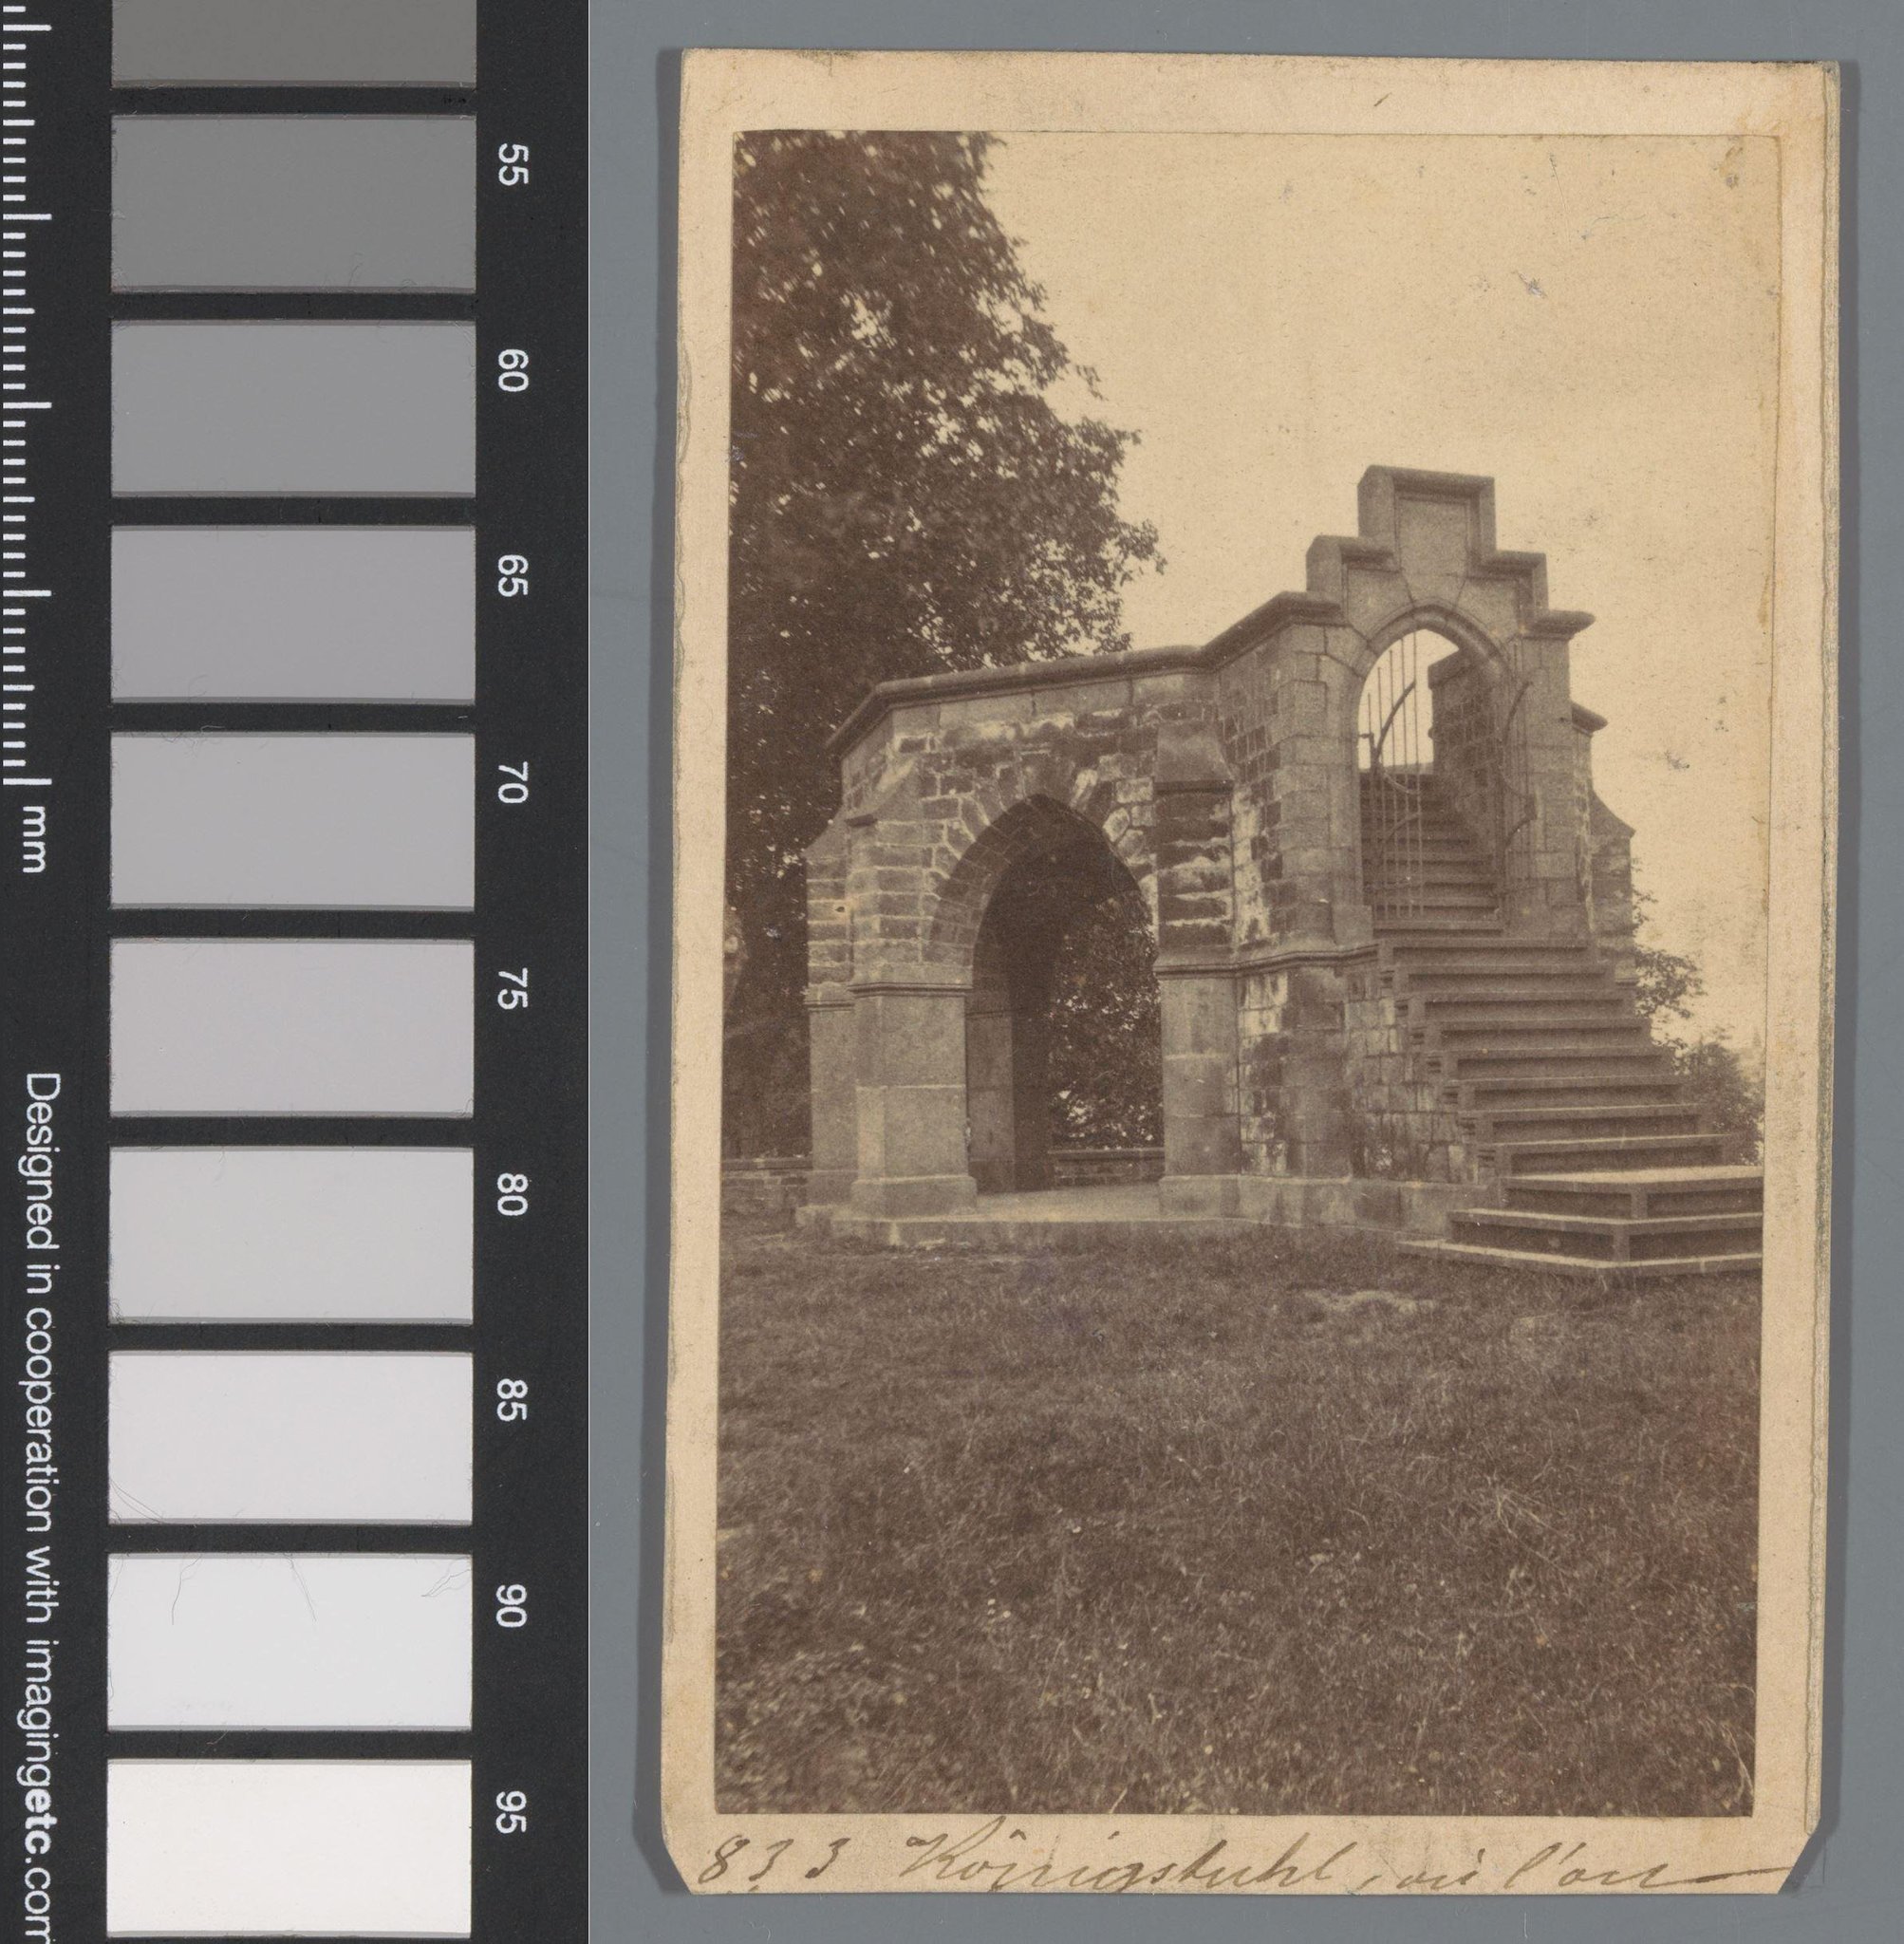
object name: photograph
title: Königsstuhl von Rhens in Rhens am Rhein, Duitsland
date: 1857-1866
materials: cardboard, paper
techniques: albumen print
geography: rhens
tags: landscape with tower or castle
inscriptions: inscription: ‘AD. BRAUN./ PHOTOGRAPHE/ DE/ S.M. L'EMPEREUR/ à Dornach (Ht. Rhin)’, inscription: ‘833 Kônigsthul [...]’